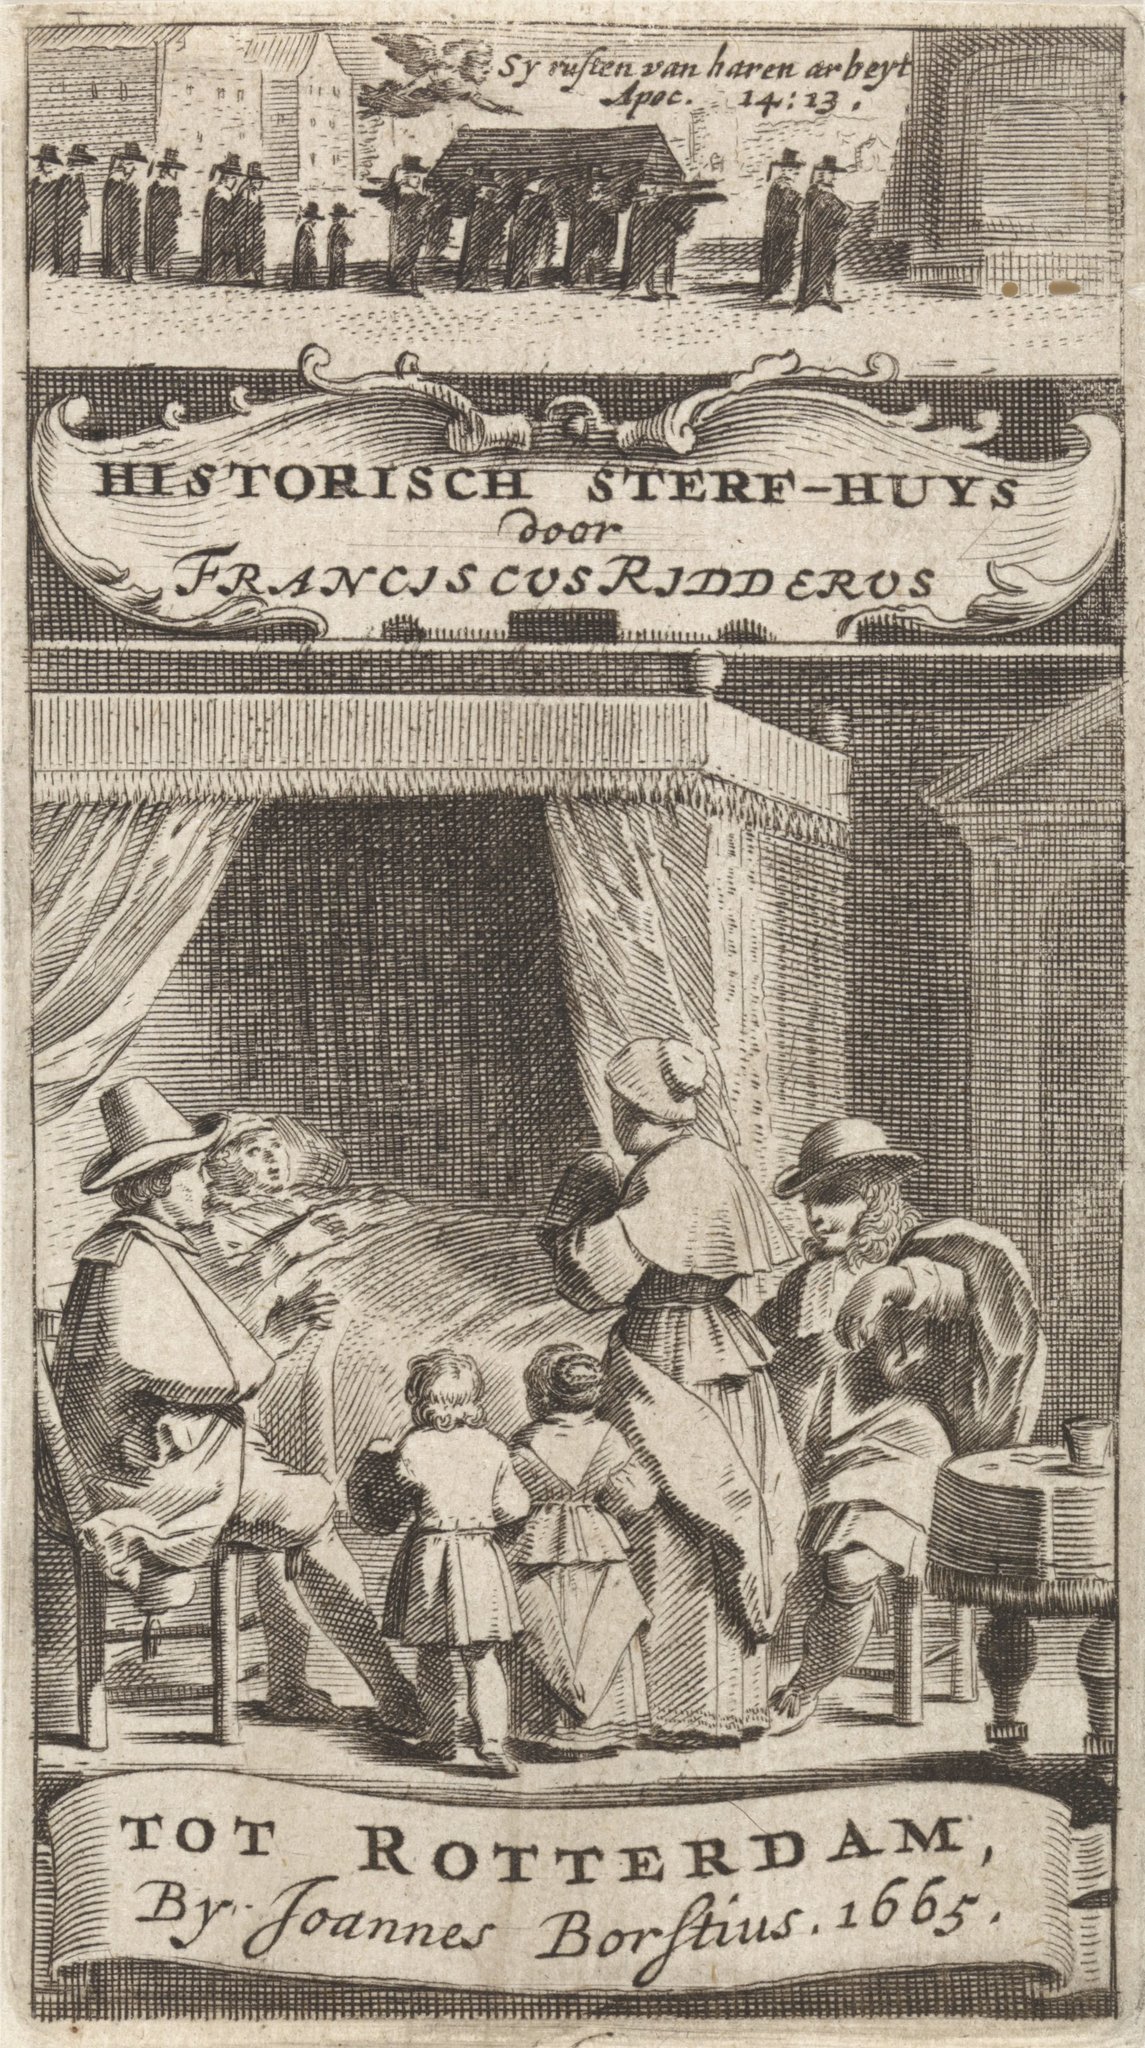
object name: titelblad, titelpagina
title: Titelpagina voor: F. Ridderus, Historisch sterf-huys, 1665.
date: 1665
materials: paper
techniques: engraving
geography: rotterdam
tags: deathbed, bed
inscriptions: collector's mark: Lugt 2228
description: Een vrouw op haar sterfbed, omringd door drie figuren en twee kinderen. Onderaan een banderol met het impressum, bovenaan de titel op en cartouche. Op het bovenste gedeelte van de prent een lijkstatie, waarboven een engel en een Bijbeltekst in het het Nederlands: Apoc. 14:13.